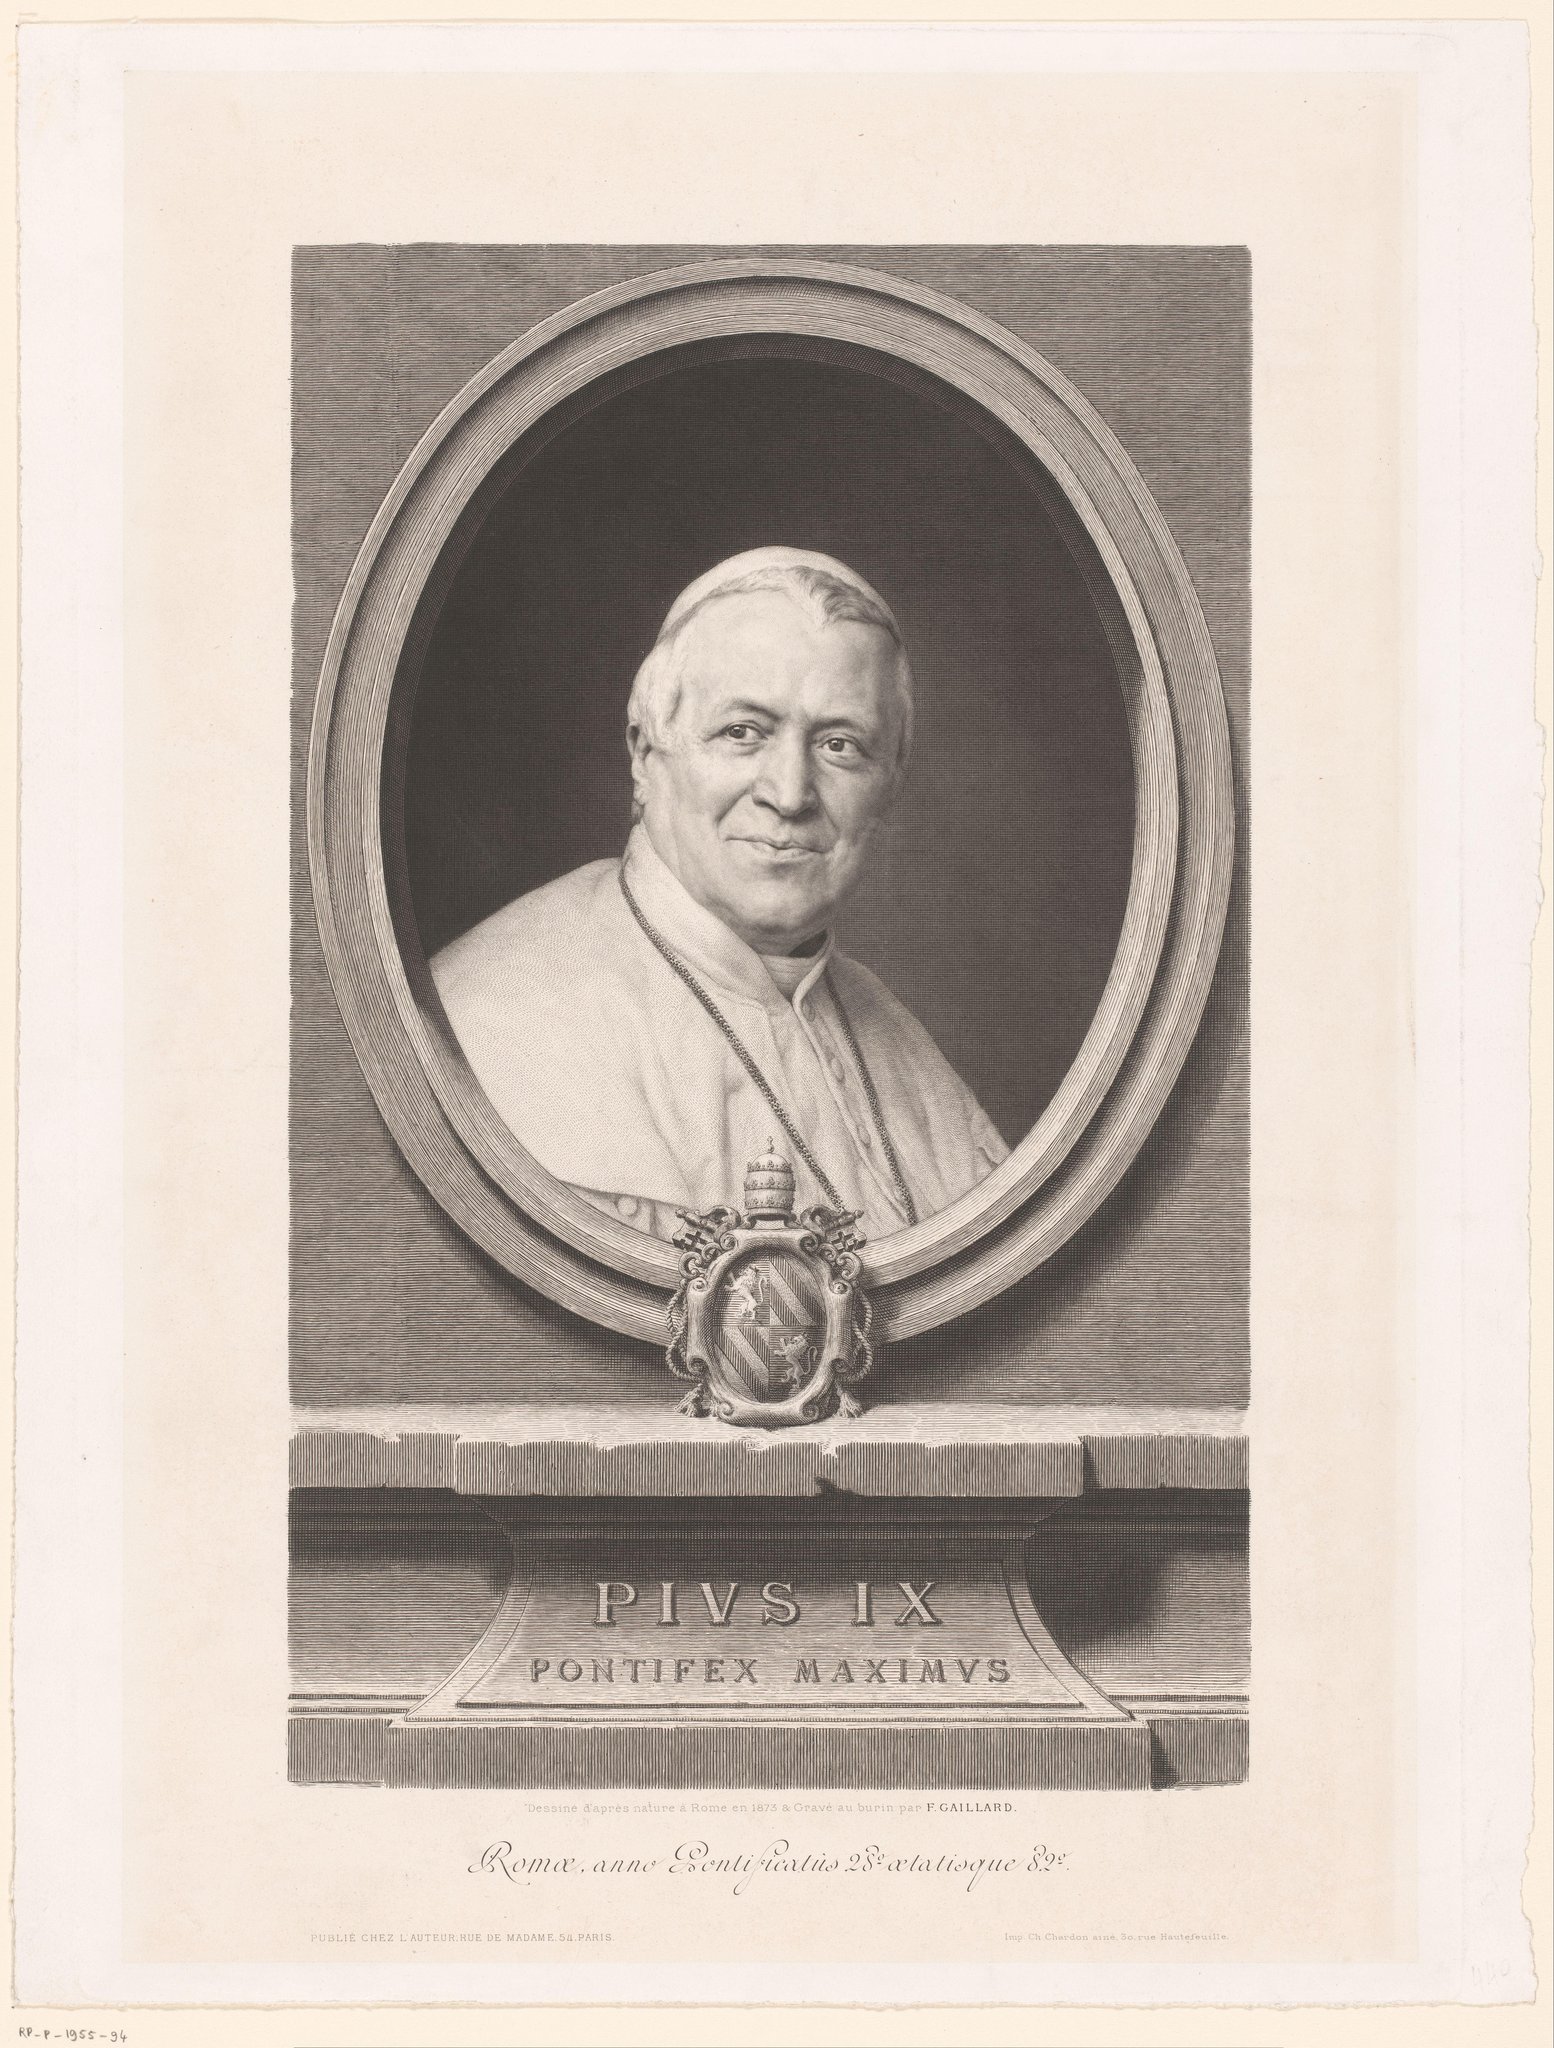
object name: print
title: Portret van Pius IX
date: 1873-1887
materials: paper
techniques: engraving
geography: paris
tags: rome, historical persons, pope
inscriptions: collector's mark: Lugt 2228